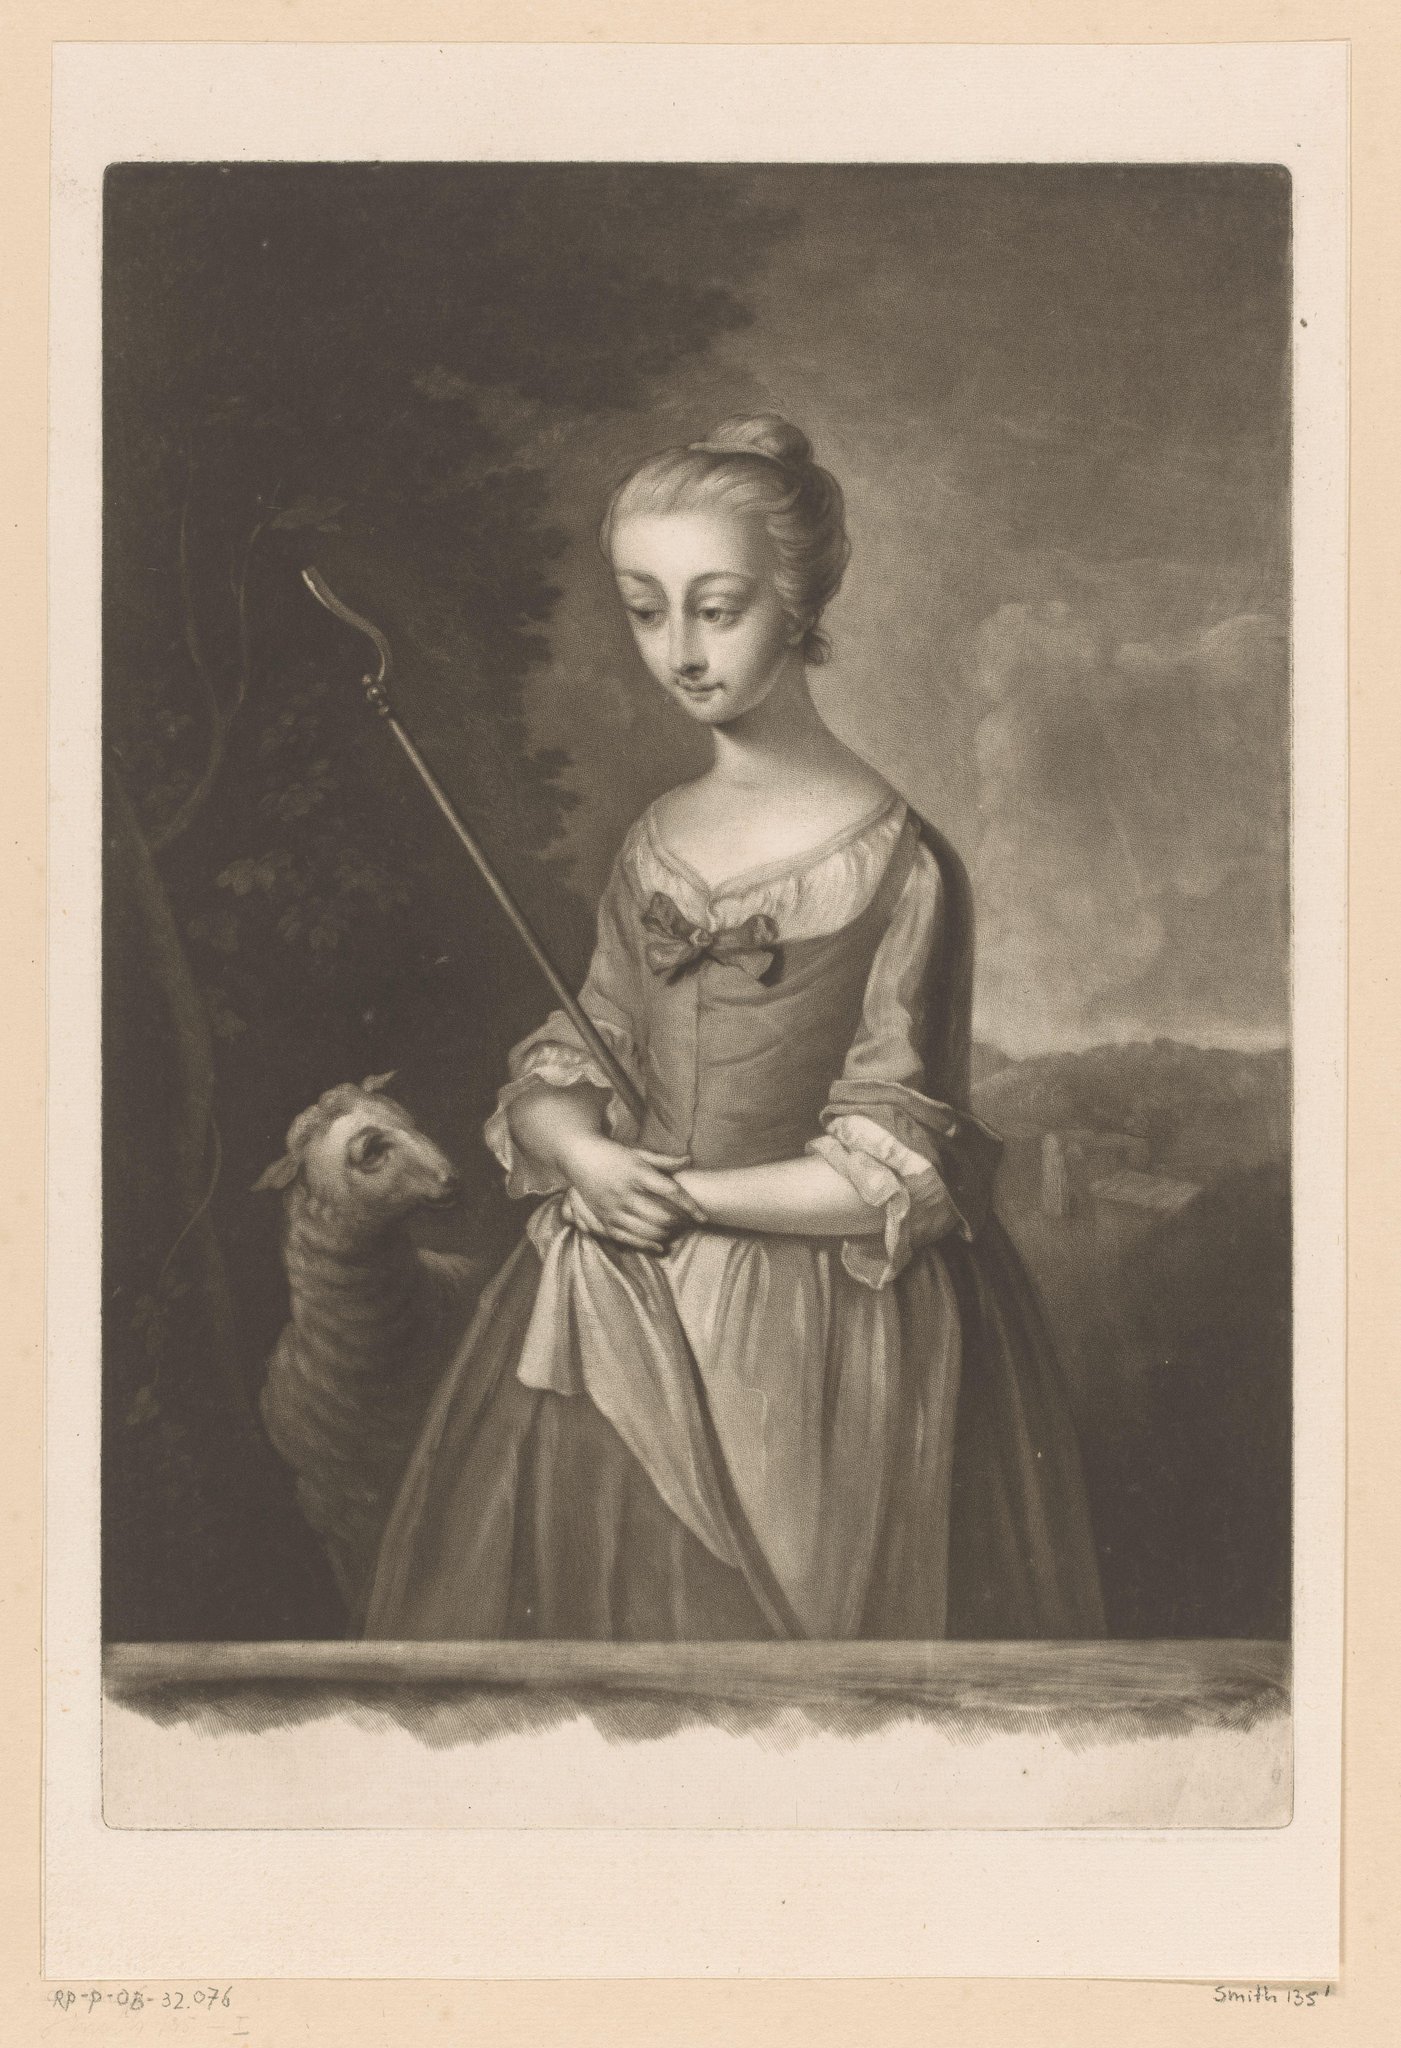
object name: print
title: Herderin met een lam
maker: richard houston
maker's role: print maker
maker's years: 1721-1775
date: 1731-1775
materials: paper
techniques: mezzotint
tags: herding, herdsman, herdswoman, shepherd, shepherdess, cowherd, etc., lamb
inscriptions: collector's mark: Lugt 240